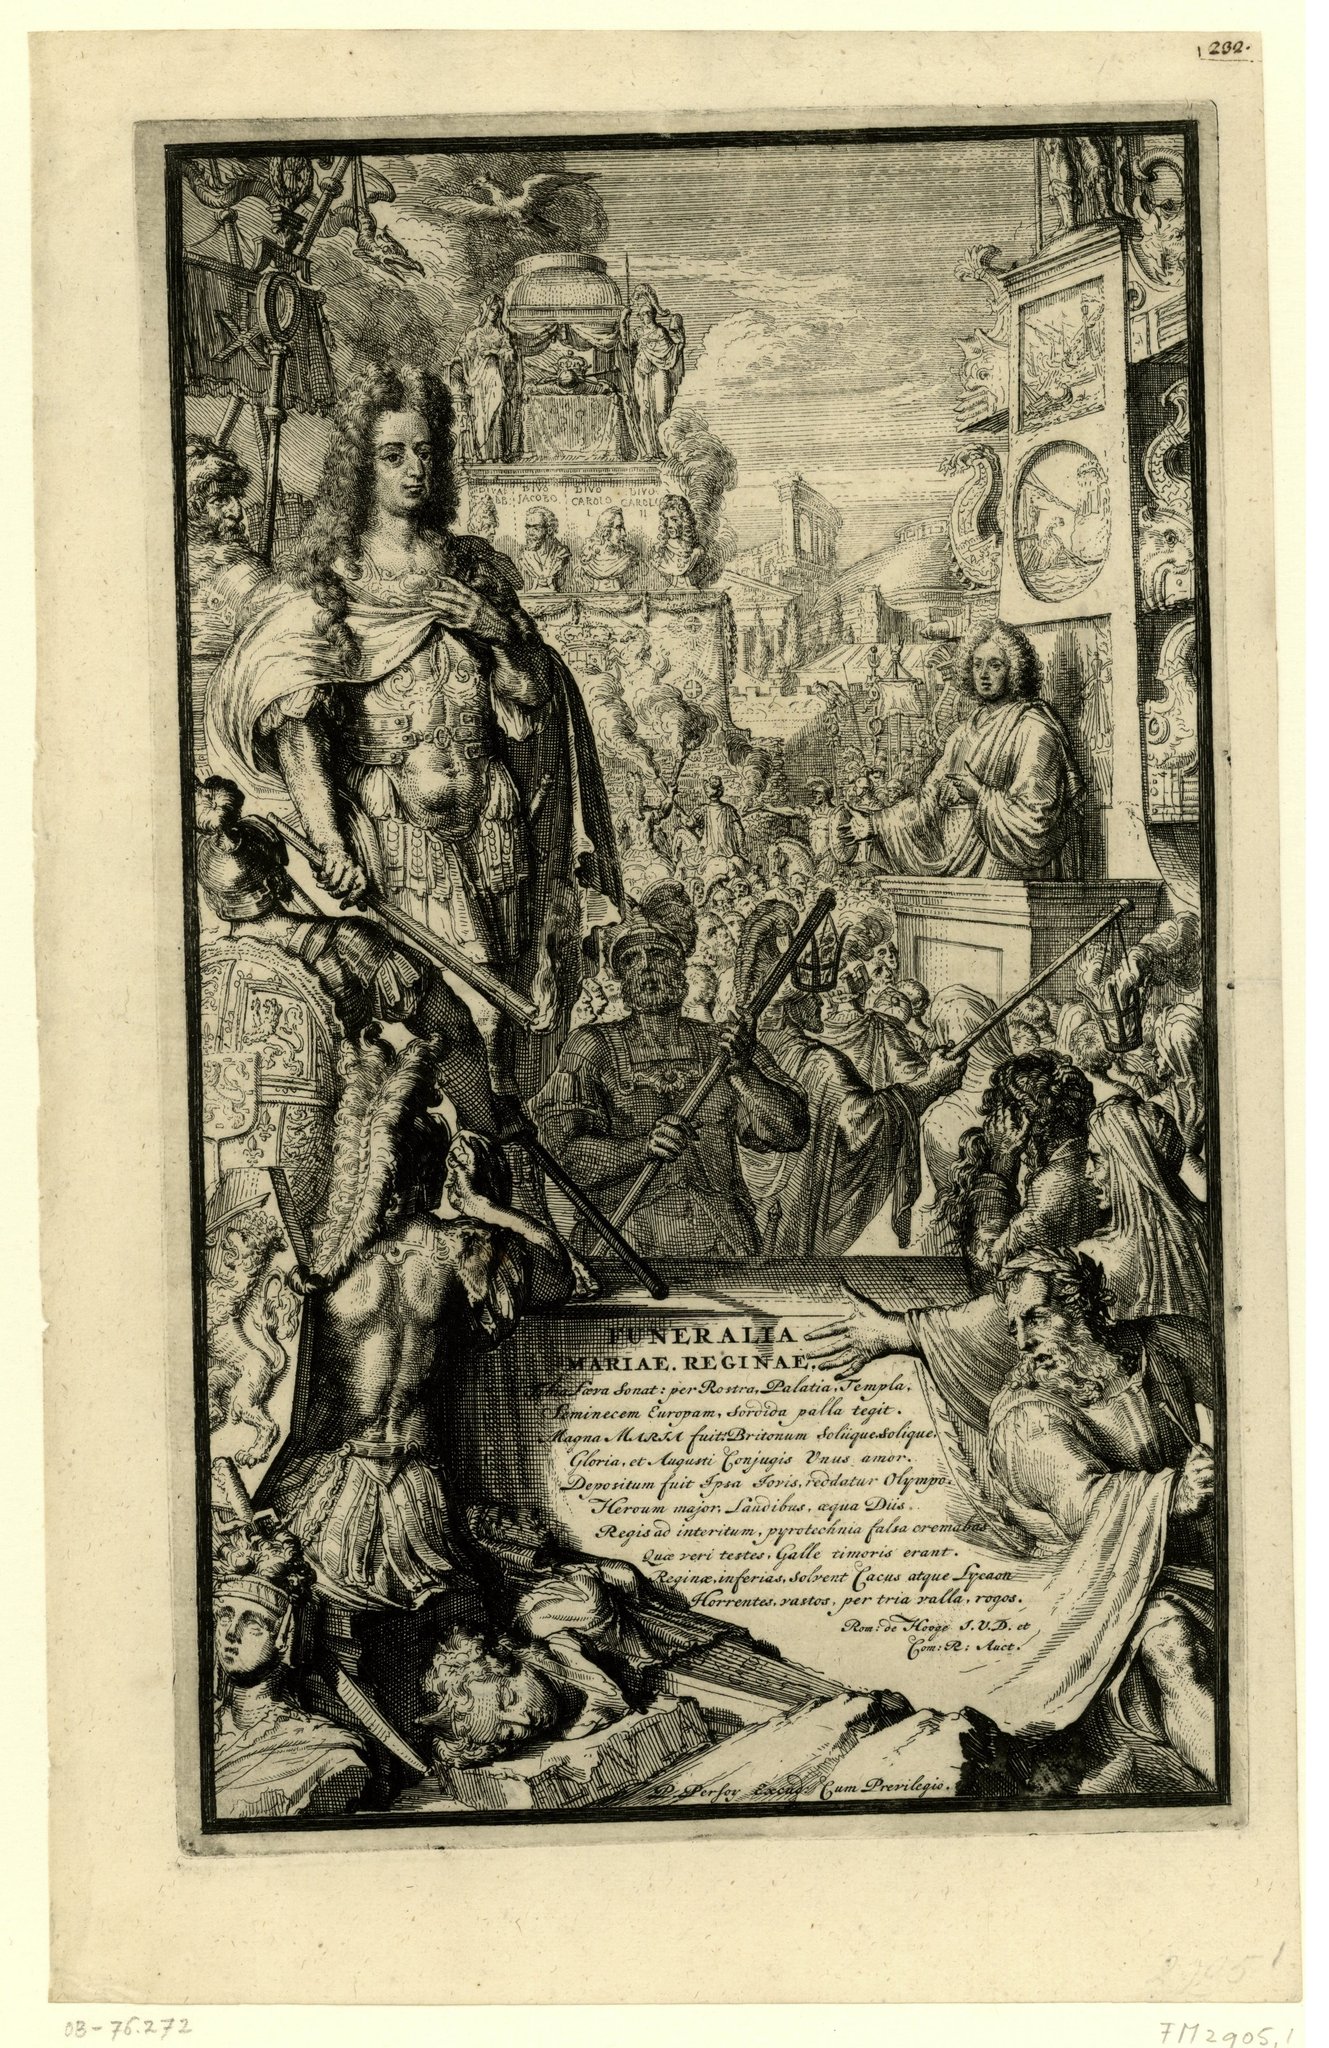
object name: print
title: Het overlijden en de lijkstatie van Maria II Stuart, koningin van Engeland, 1695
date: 1695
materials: paper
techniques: etching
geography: northern netherlands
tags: the hague, william iii (prince of orange and king of england, scotland, and ireland), london, maria ii stuart (koningin van engeland, schotland en ierland), samuel gruterus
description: Titelpagina van het boek 'Funeralia Mariae II Britanniarum', van Samuel Gruterus uit 1695, waarin de serie prenten over het overlijden en de lijkstatie van Maria Stuart zijn afgebeeld. Allegorische titelprent met links koning Willem III als een Romeins veldheer met een fakkel in de hand, rechts Samuel Gruterus als een redenaar achter een kansel. Onderaan een Latijns vers van Romeyn de Hooghe. Bij de prent behoort een verklaring van de voorstelling (RP-P-OB-76.272A).